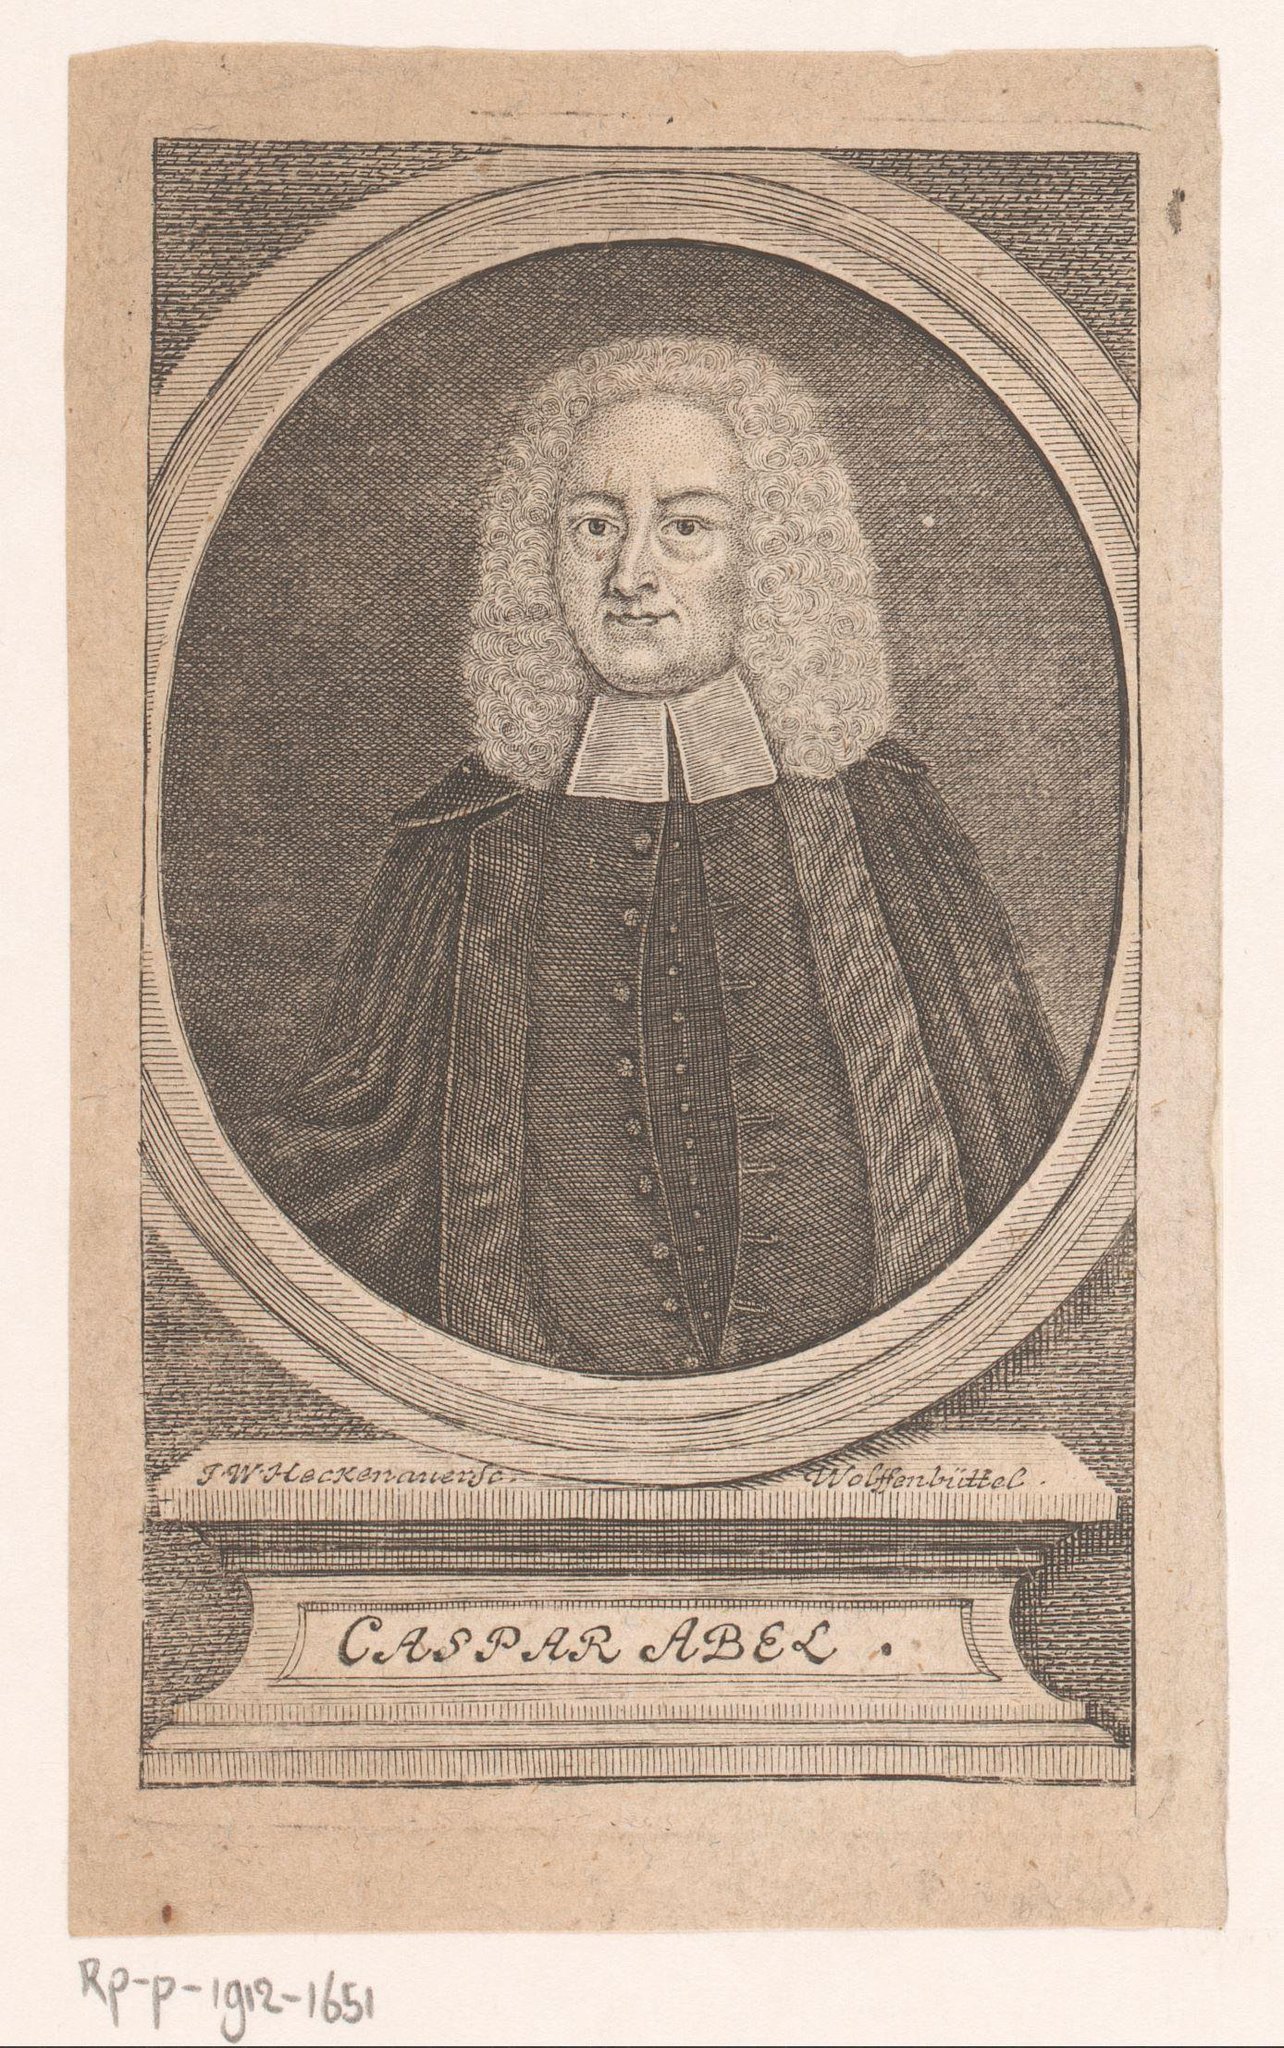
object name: print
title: Portret van Caspar Abel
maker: jakob wilhelm heckenauer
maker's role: print maker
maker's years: 1696-1738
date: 1686-1738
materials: paper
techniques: engraving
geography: wolfenbüttel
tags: theologian, historical persons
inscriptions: collector's mark: Lugt 2228